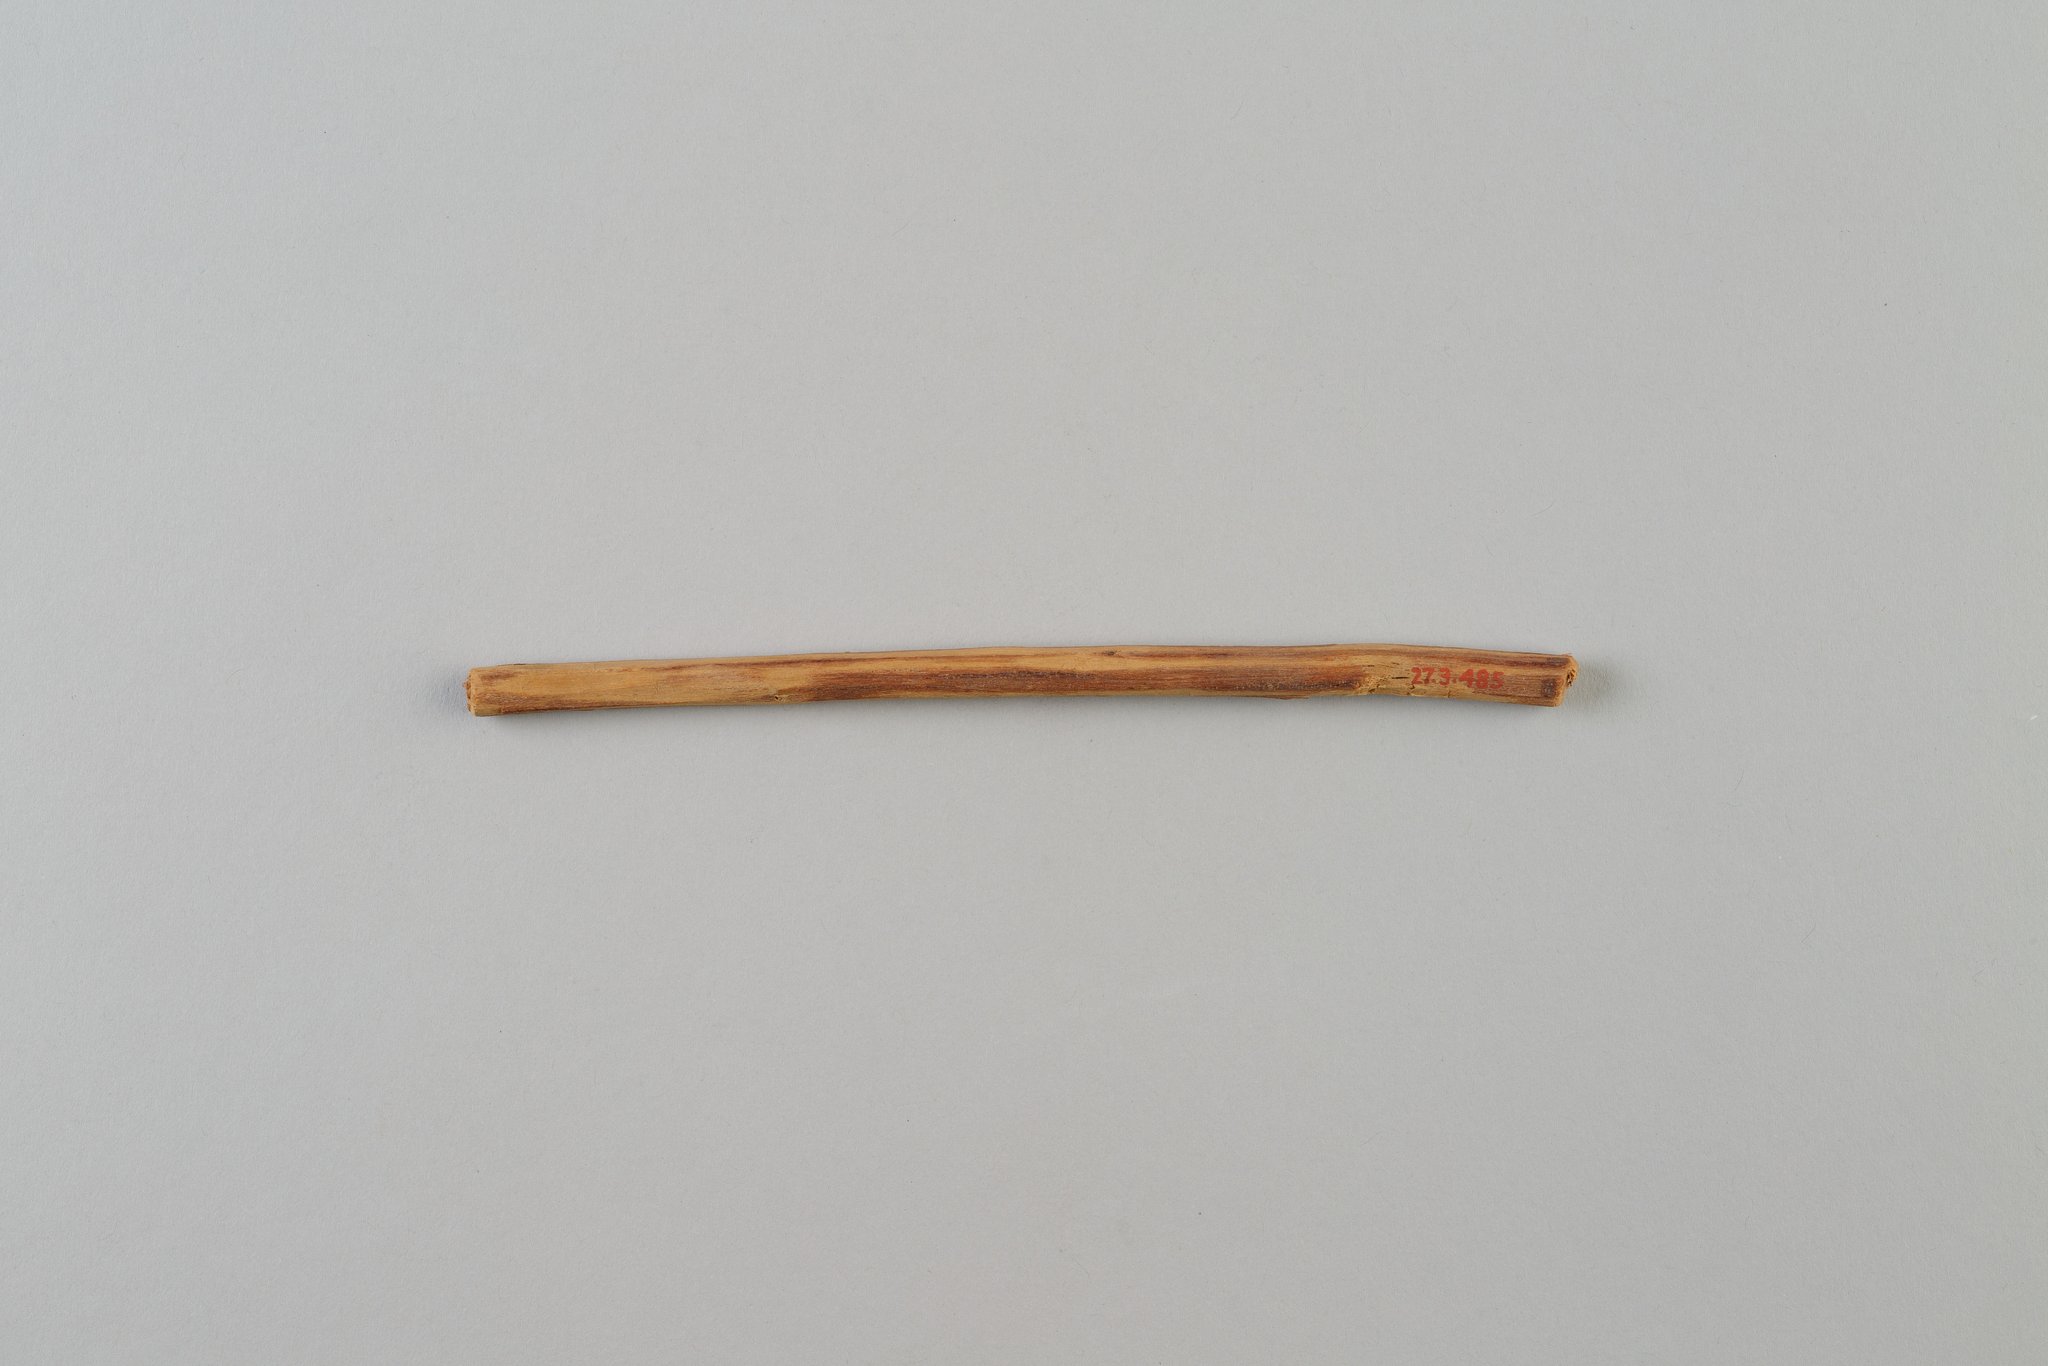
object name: lever, model, tool, senenmut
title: Model Tool from a Foundation Deposit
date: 1479-1458 BCE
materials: wood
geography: egypt